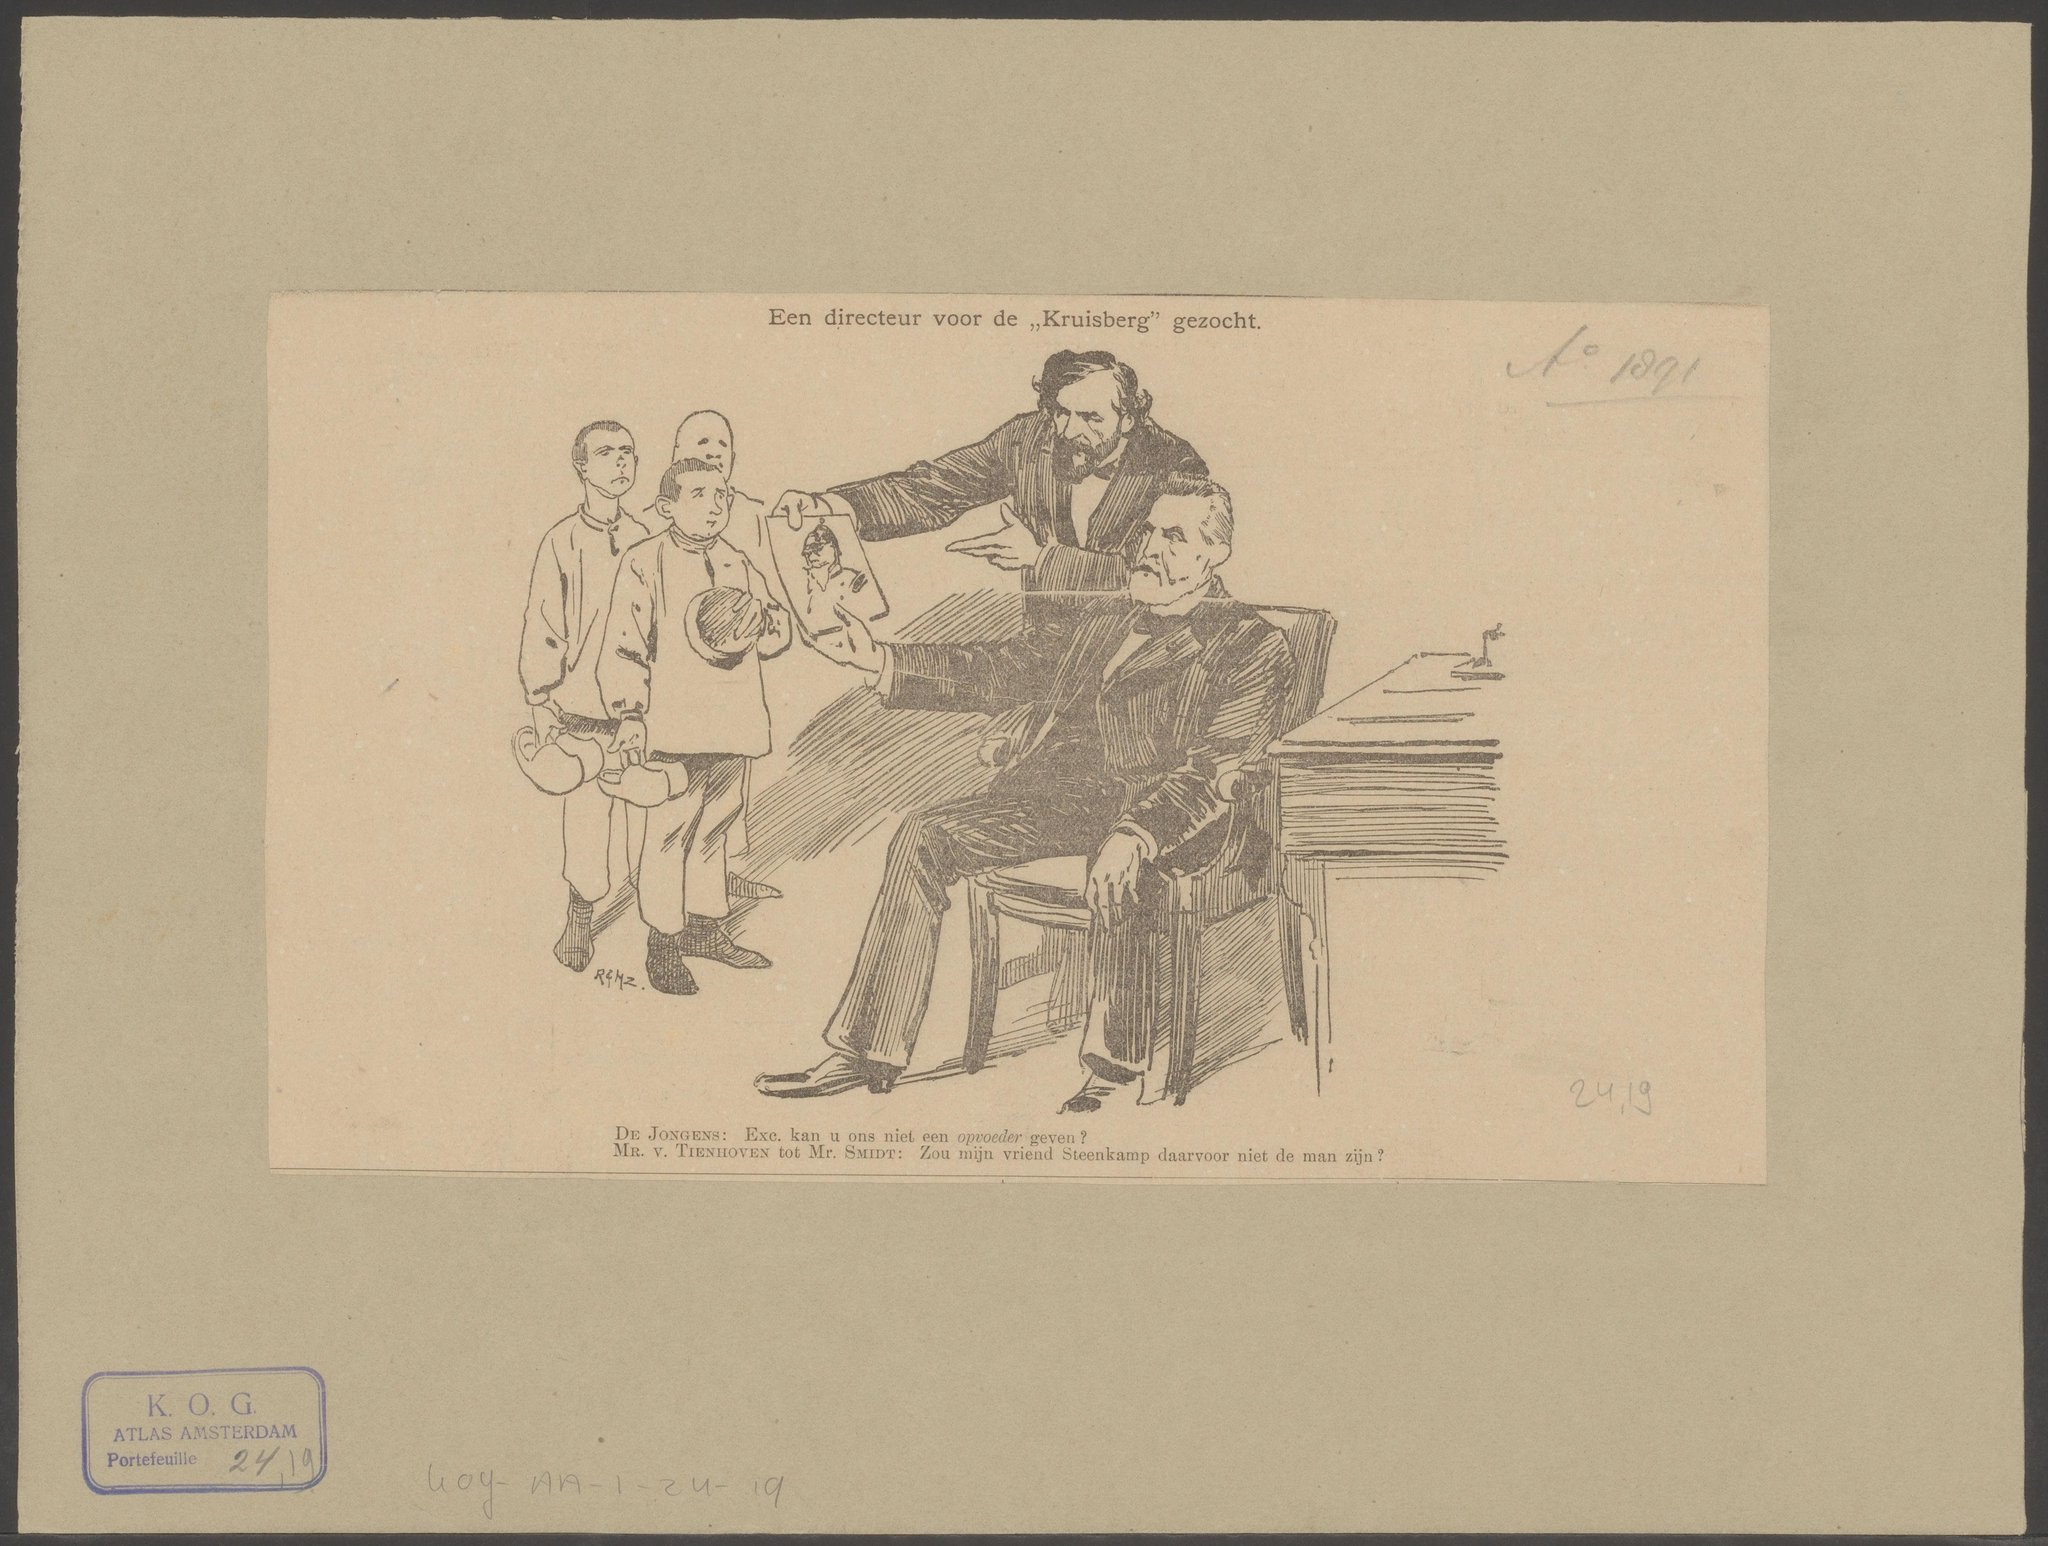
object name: cartoon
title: Een directeur voor de "Kruisberg" gezocht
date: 1892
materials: paper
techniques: letterpress printing, line block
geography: netherlands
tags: the hague, mayor, gijsbert van tienhoven, political caricatures and satires, amsterdam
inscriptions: signature: ‘R&Hz.’, collector's mark: Lugt 1641b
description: Prent uit: De Amsterdammer 16 (1892), nr. 774, 24 april 1892, p. 7.